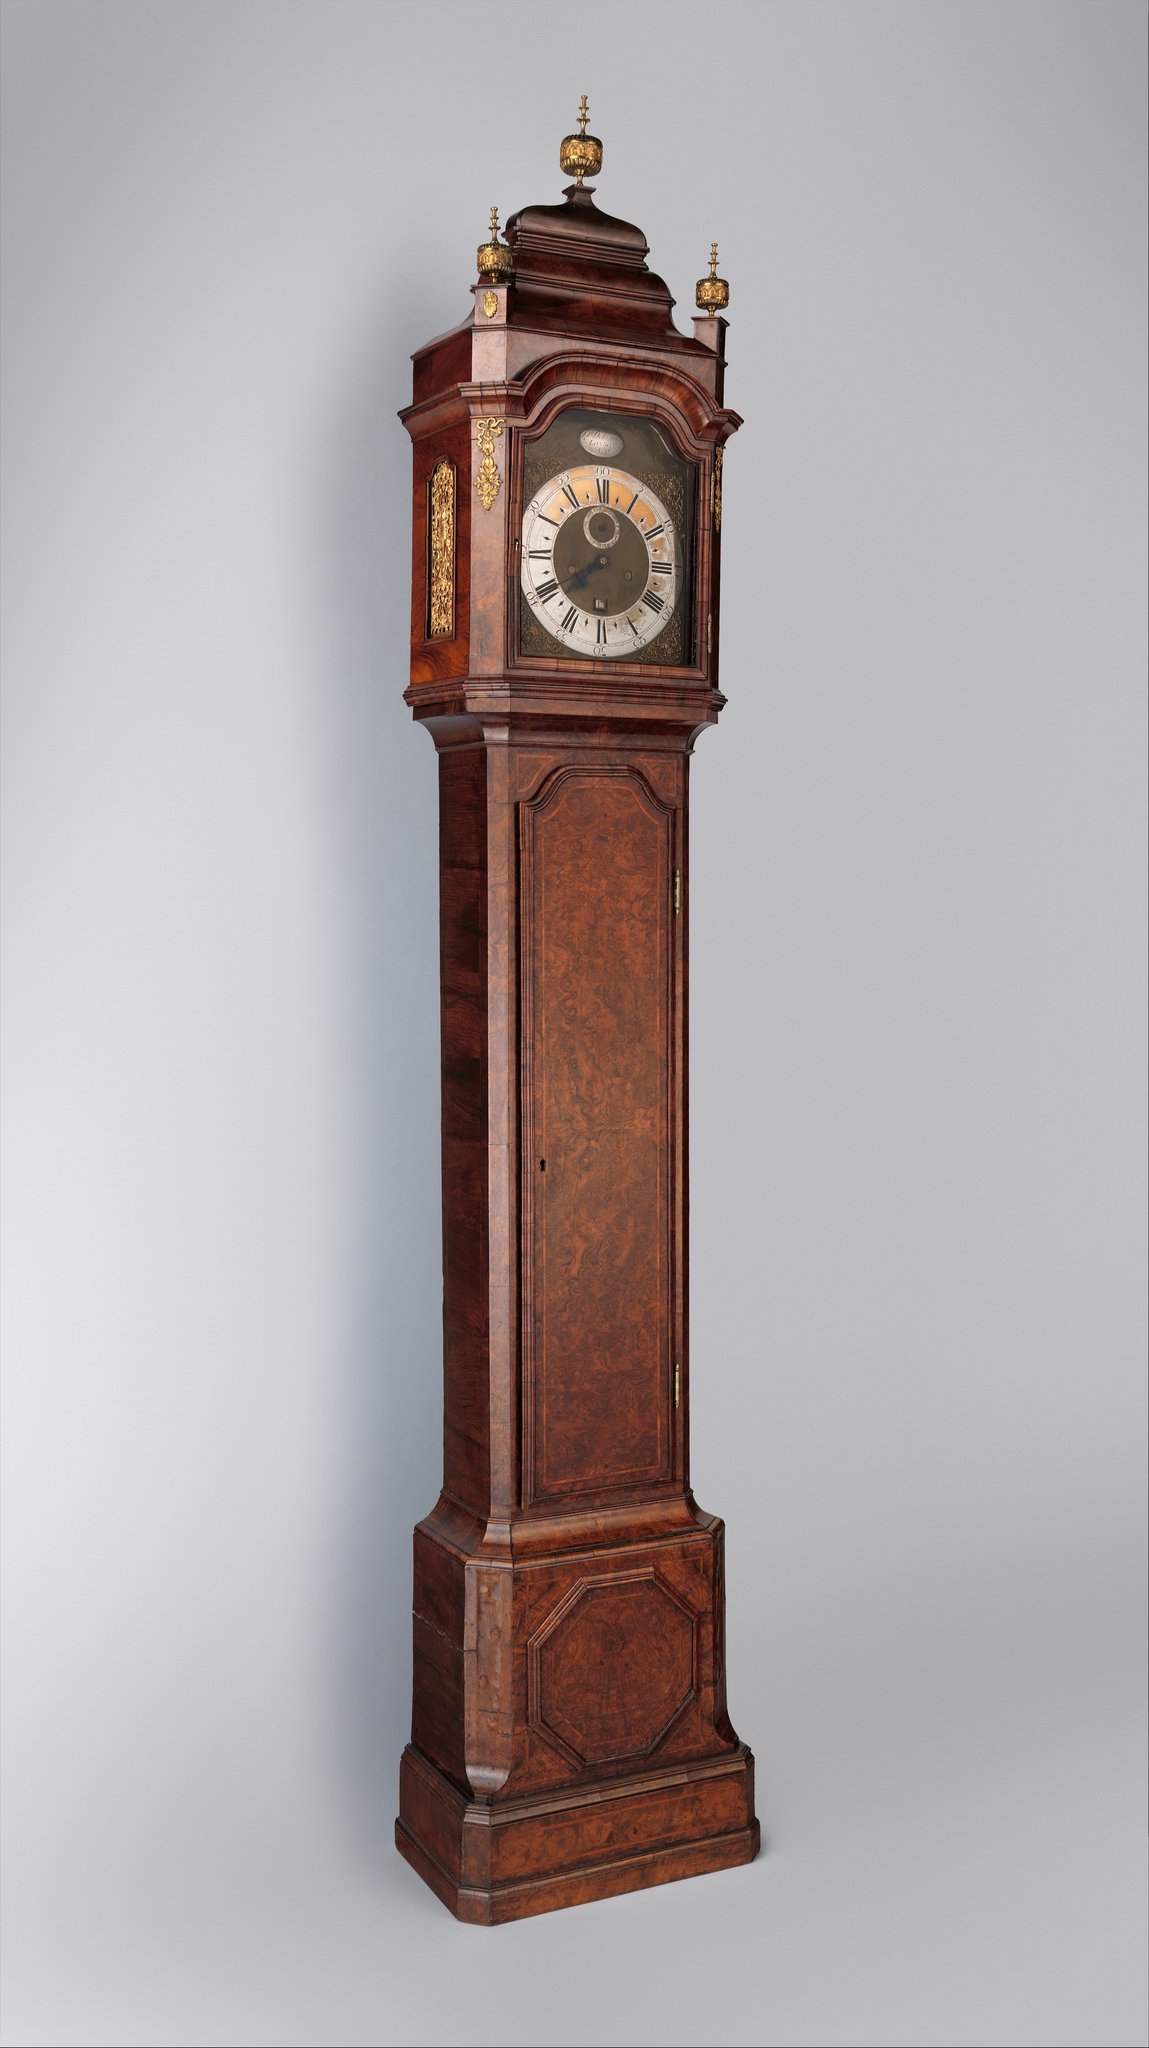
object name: longcase clock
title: Longcase clock with calendar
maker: daniel delander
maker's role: maker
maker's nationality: british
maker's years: 1678-1733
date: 1720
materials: brass, gilt brass, wood, steel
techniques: gilding, inlay, silvered, veneering